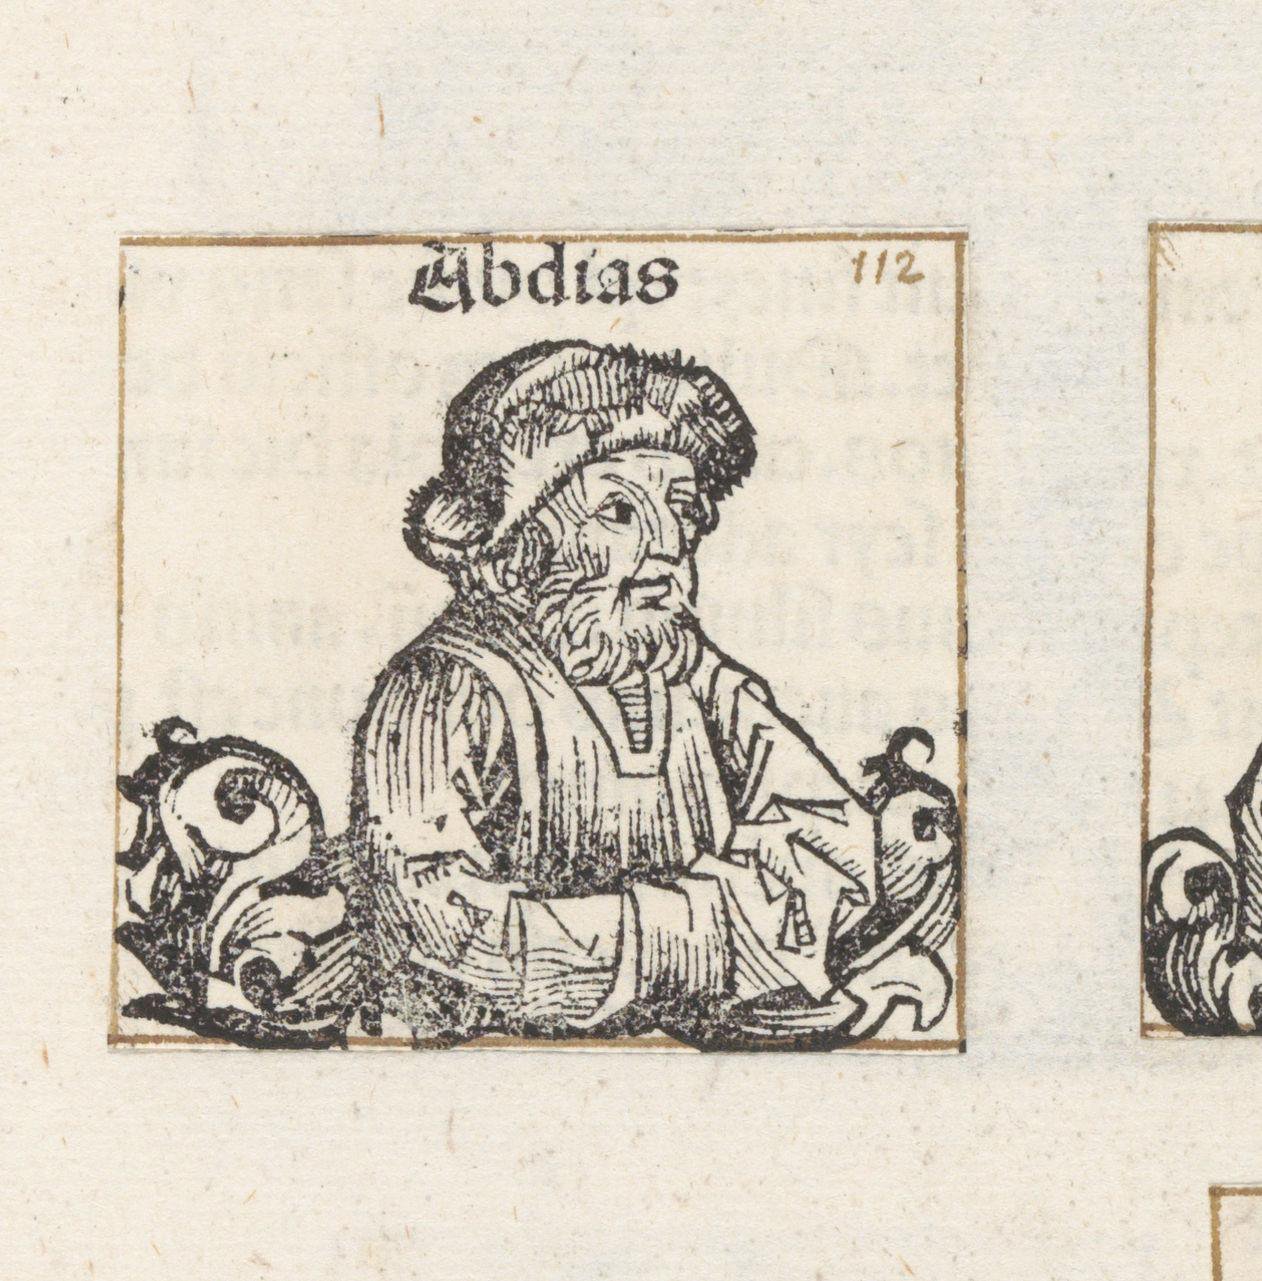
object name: book illustration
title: Obadja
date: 1493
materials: paper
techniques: letterpress printing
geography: nuremberg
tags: persons from the old testament (not in biblical context, nor occurring in legendary/historical extensions included in division 71)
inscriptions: inscription: ‘112’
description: Een bloemkelk met een man met hoed, naar rechts gericht. Hij heeft zijn handen gevouwen in zijn mouwen. De voorstelling is een fragment van de lijn van de profeten van Israël in de Liber Chronicarum. De tekst identificeert hem als de profeet Obadja. De prent maakt deel uit van een album.